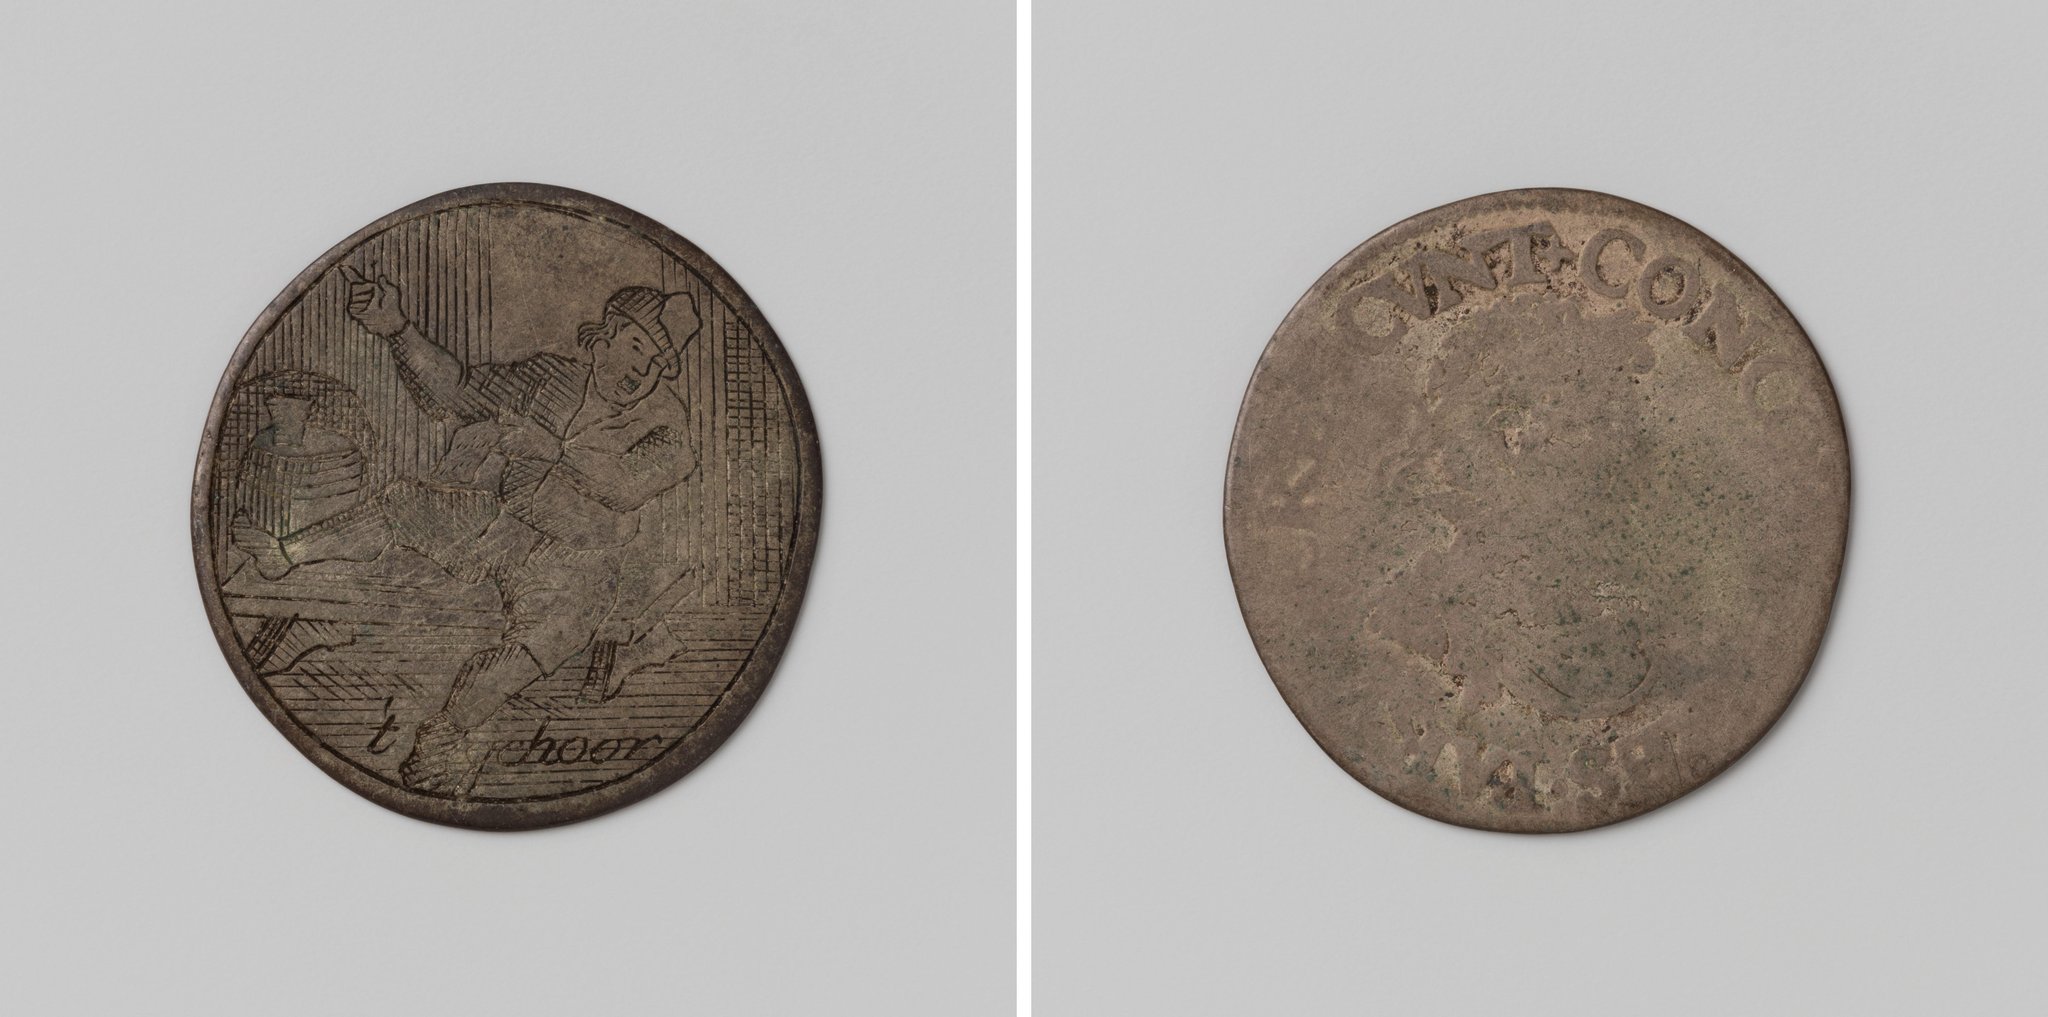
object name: stoter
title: 't Gehoor, voorstelling gegraveerd op een Leicester-stoter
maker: Anonymous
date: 1586-1597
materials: silver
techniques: engraving, striking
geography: netherlands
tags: william i (prince of orange), robert dudley (1st earl of leicester)